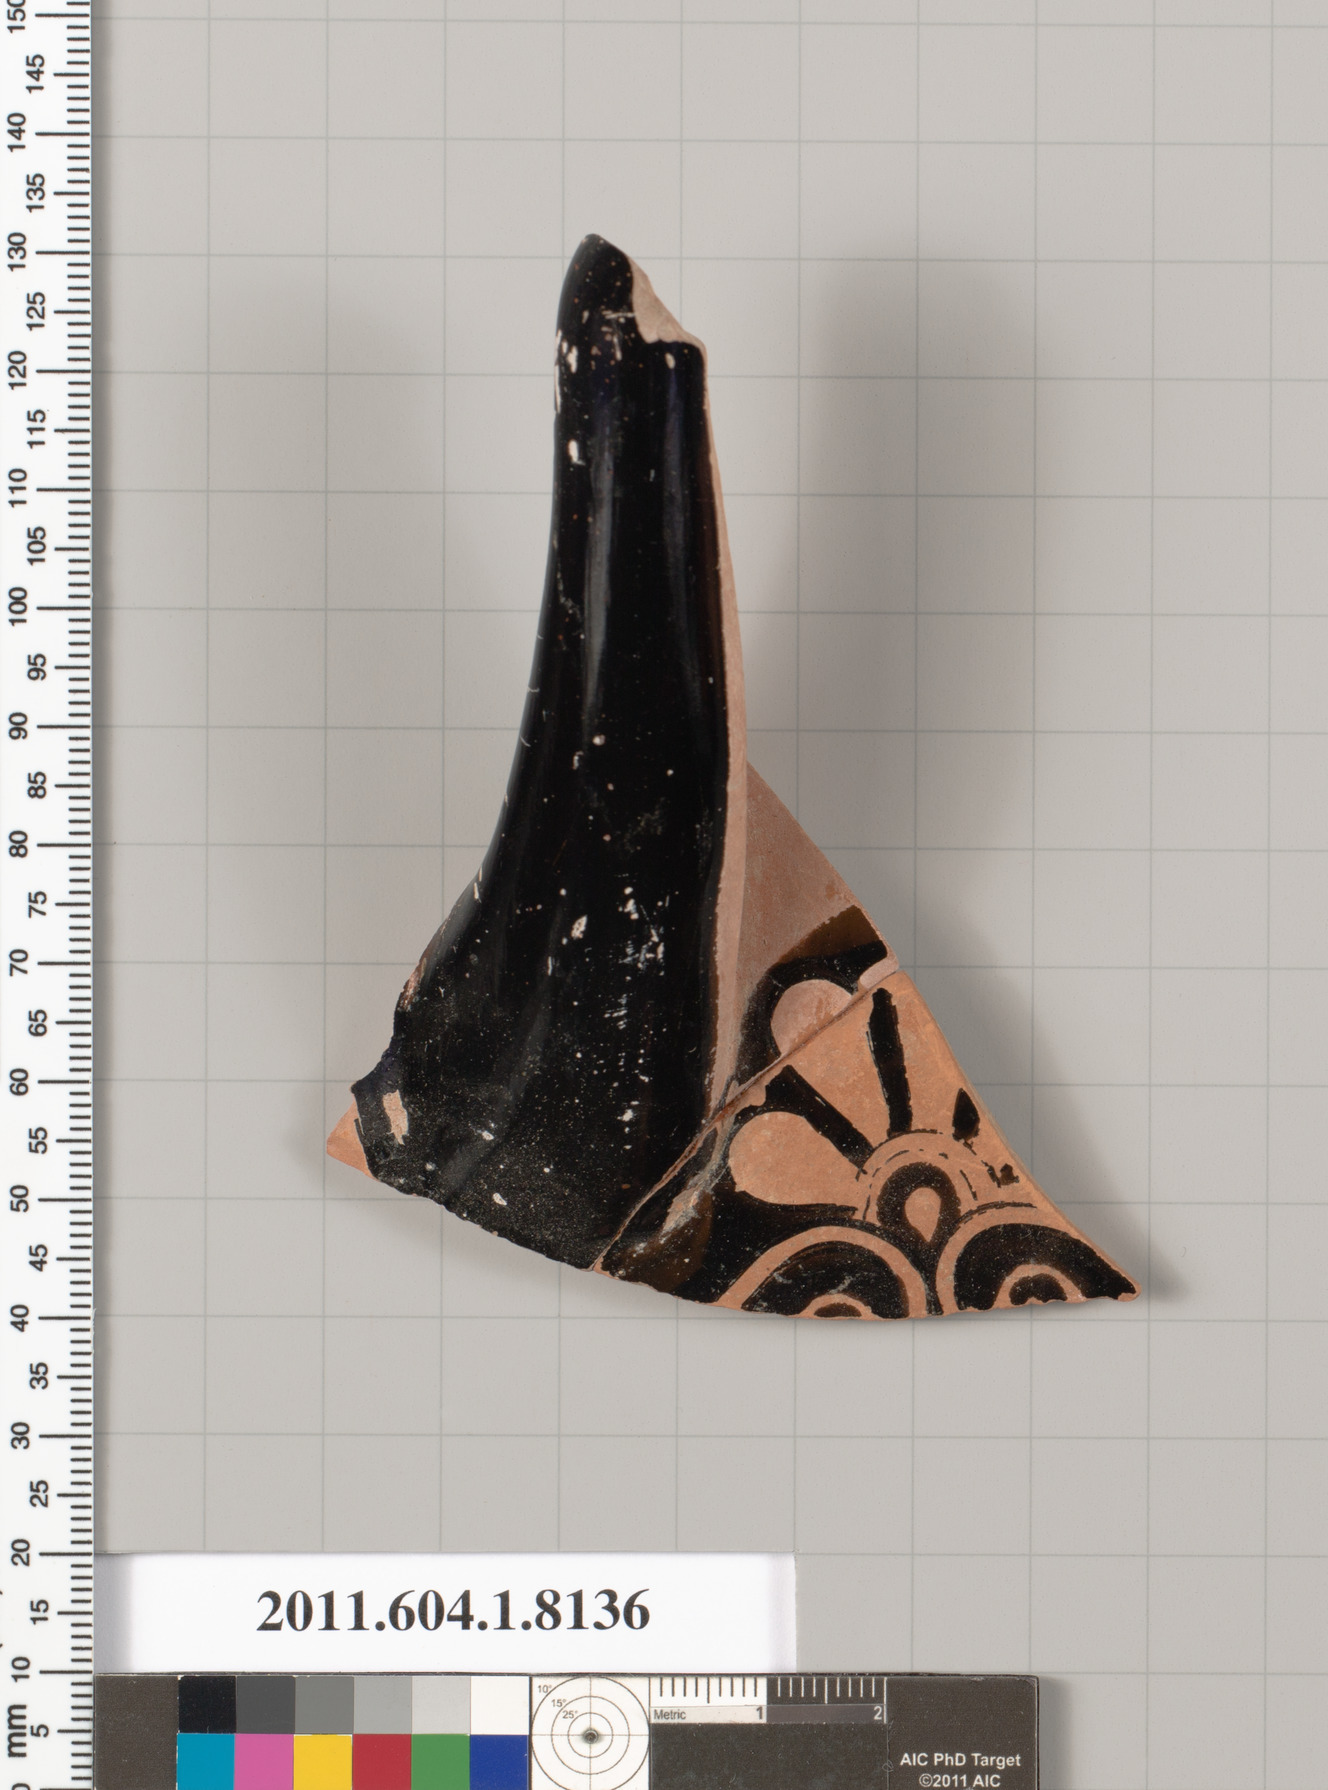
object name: kylix fragment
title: Terracotta fragment of a kylix (drinking cup)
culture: greek, attic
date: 534-468 BCE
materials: terracotta